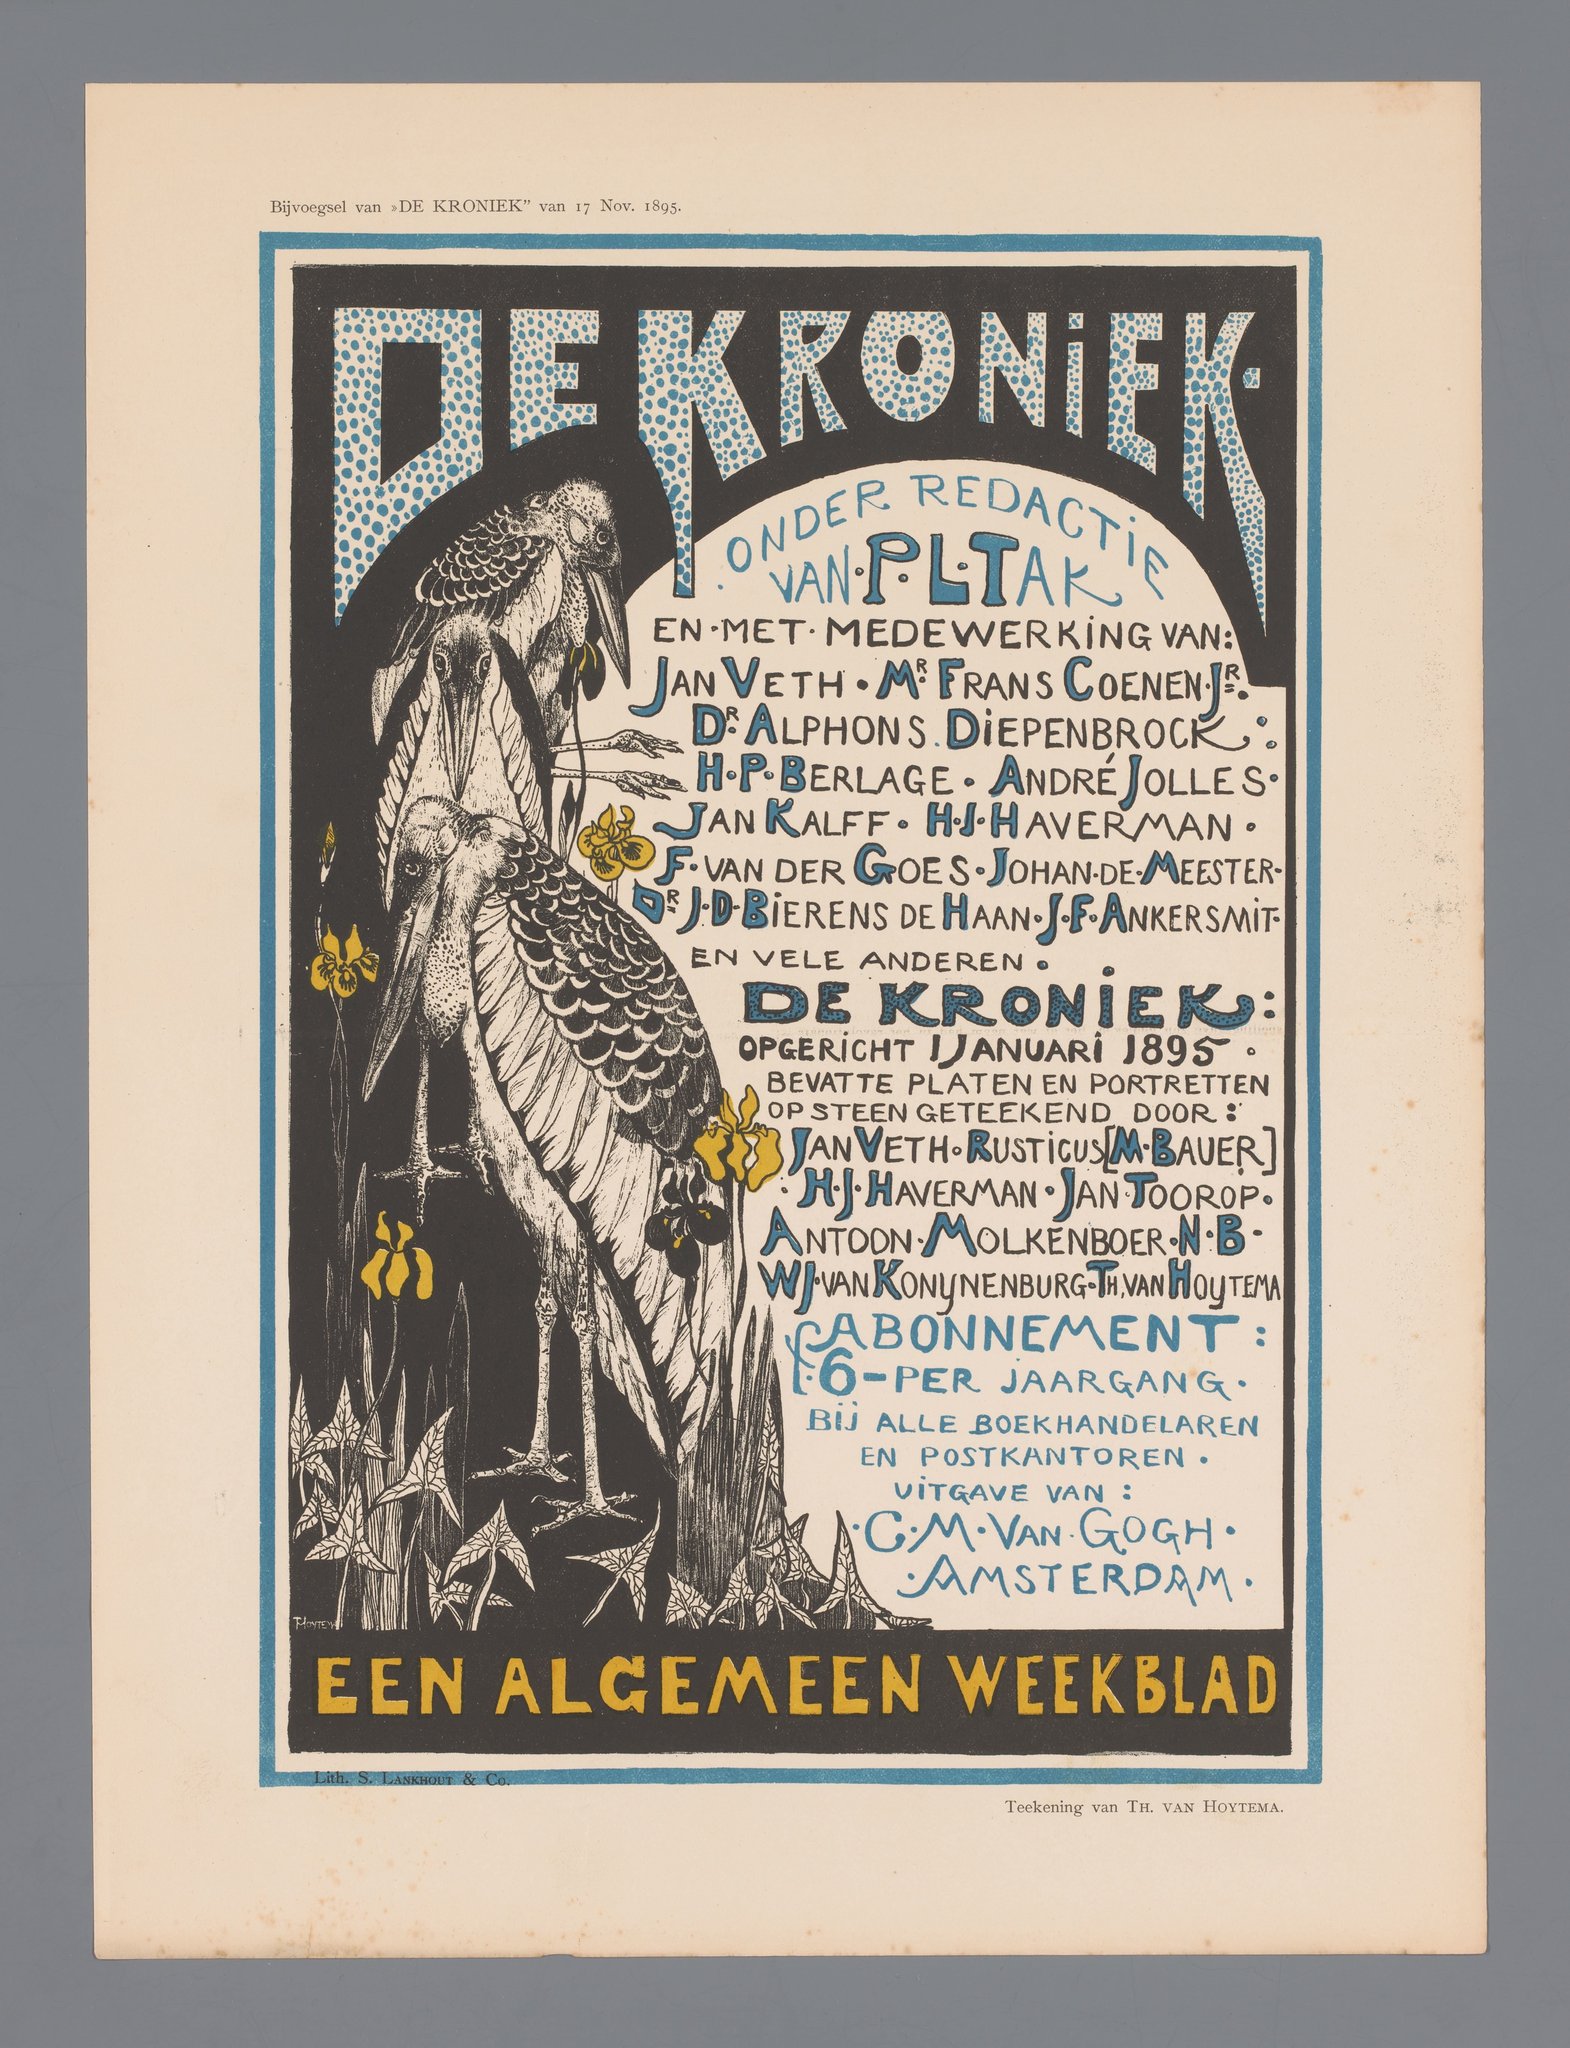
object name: print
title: De Kroniek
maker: theo van hoytema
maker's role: draughtsman, painter, print maker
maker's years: 1863-1917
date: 1895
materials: paper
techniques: lithograph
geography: the hague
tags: birds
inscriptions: date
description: Prent uit het bijvoegsel van: De Kroniek 1 (1895), 17 november 1895.